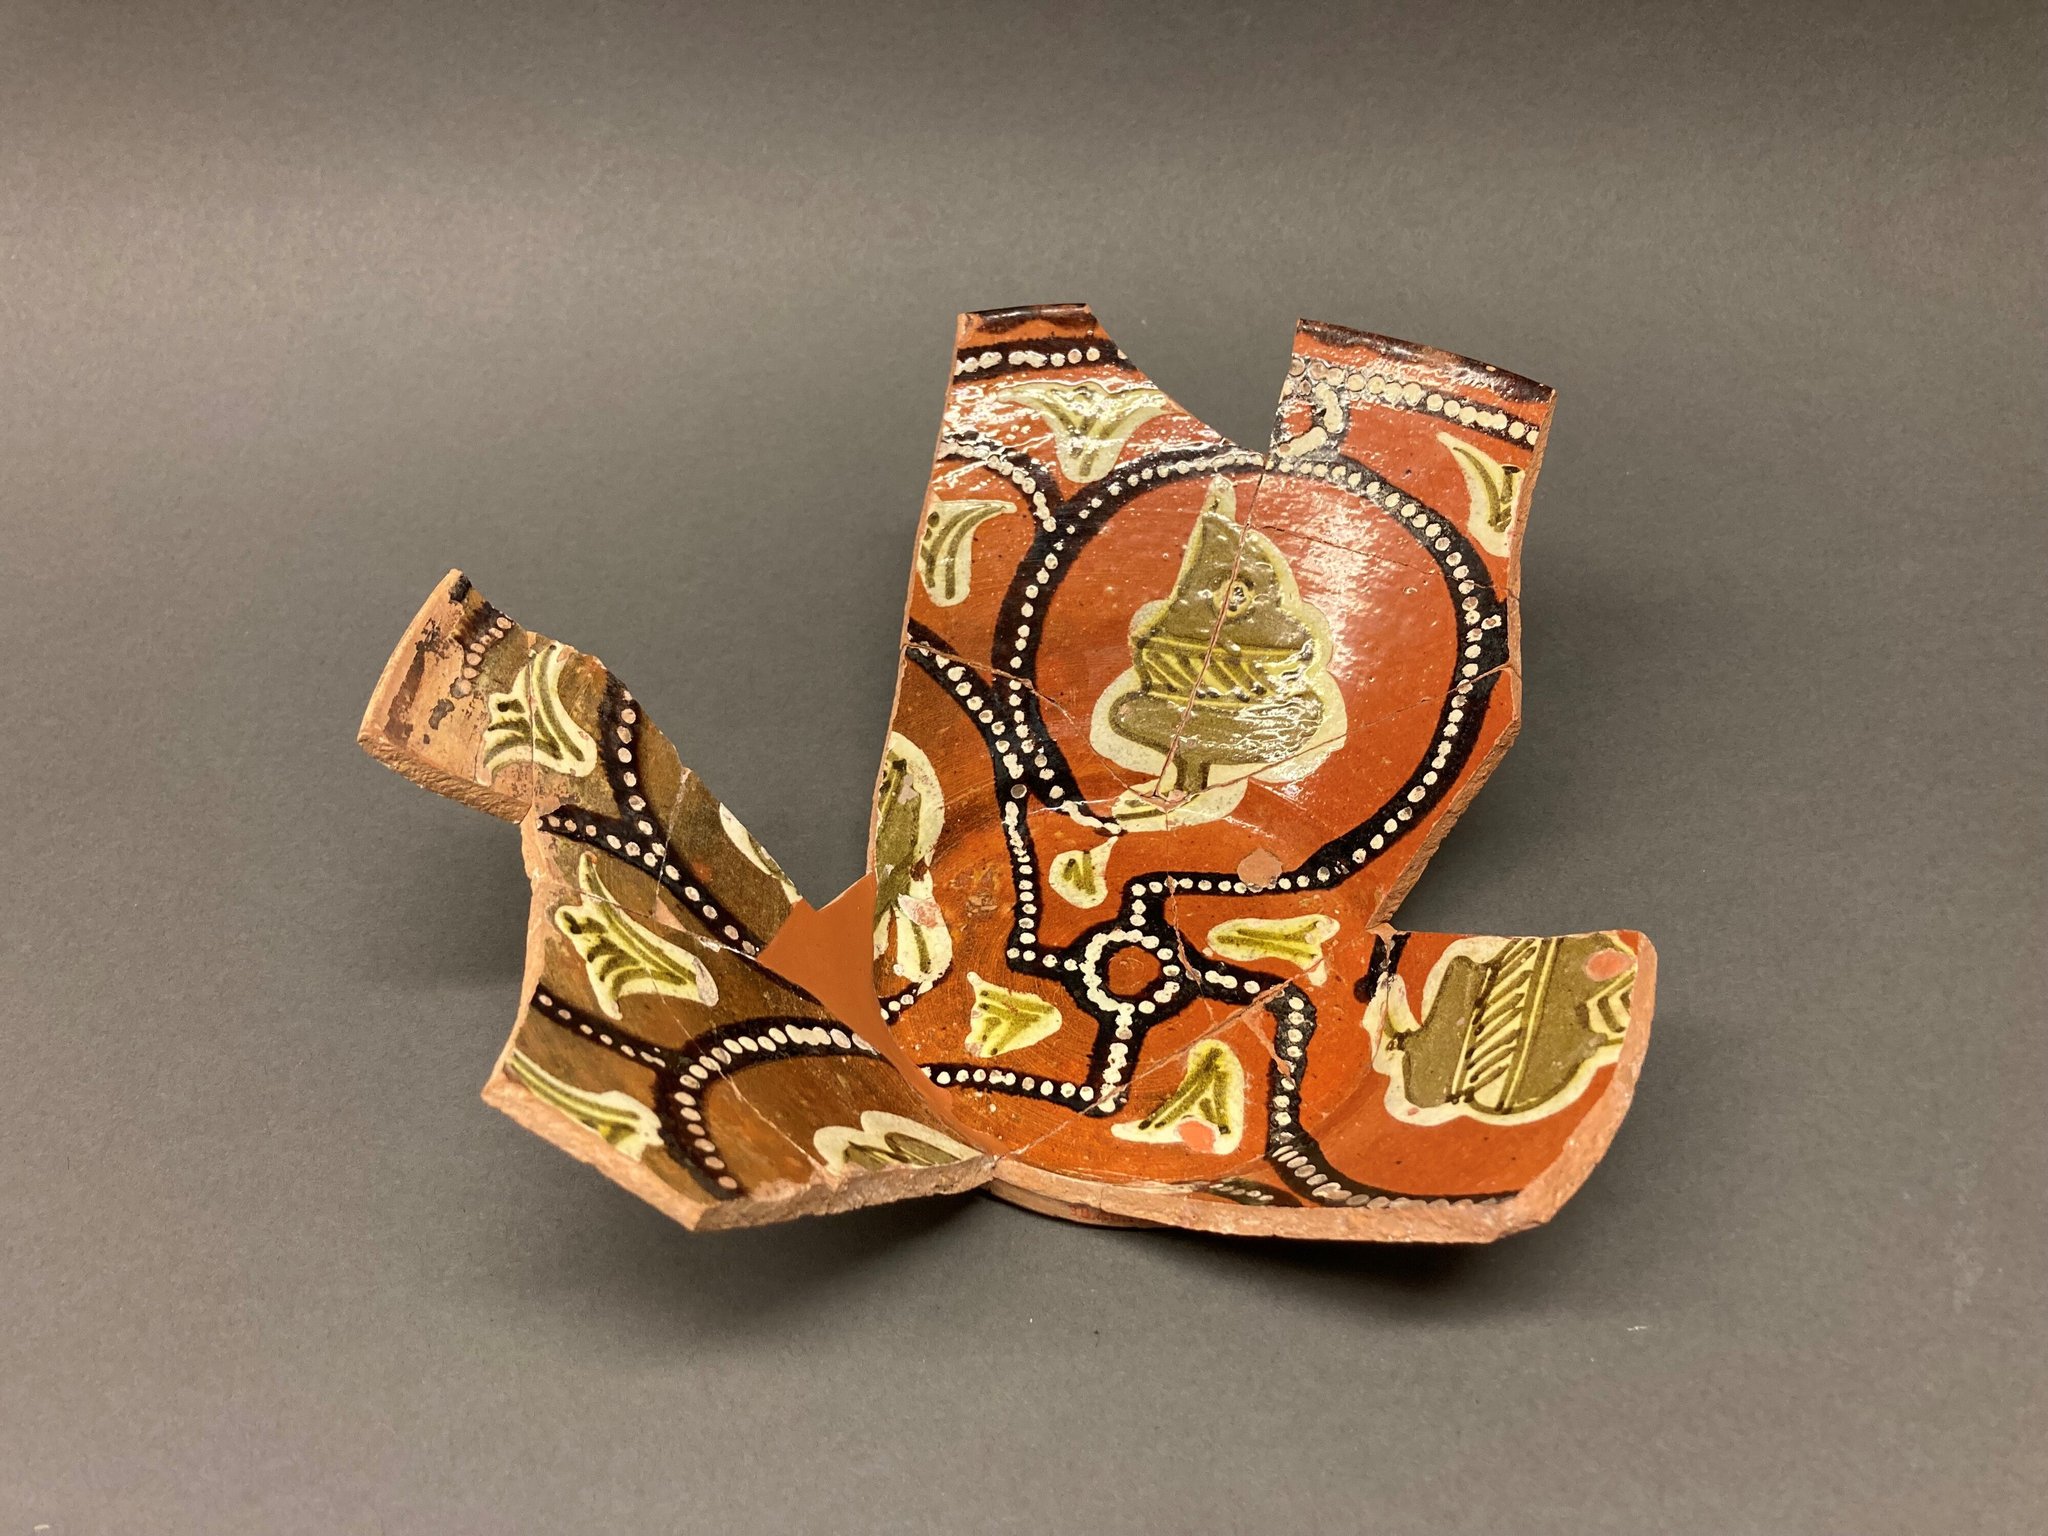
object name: bowl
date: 801-1000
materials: earthenware, glaze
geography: iran